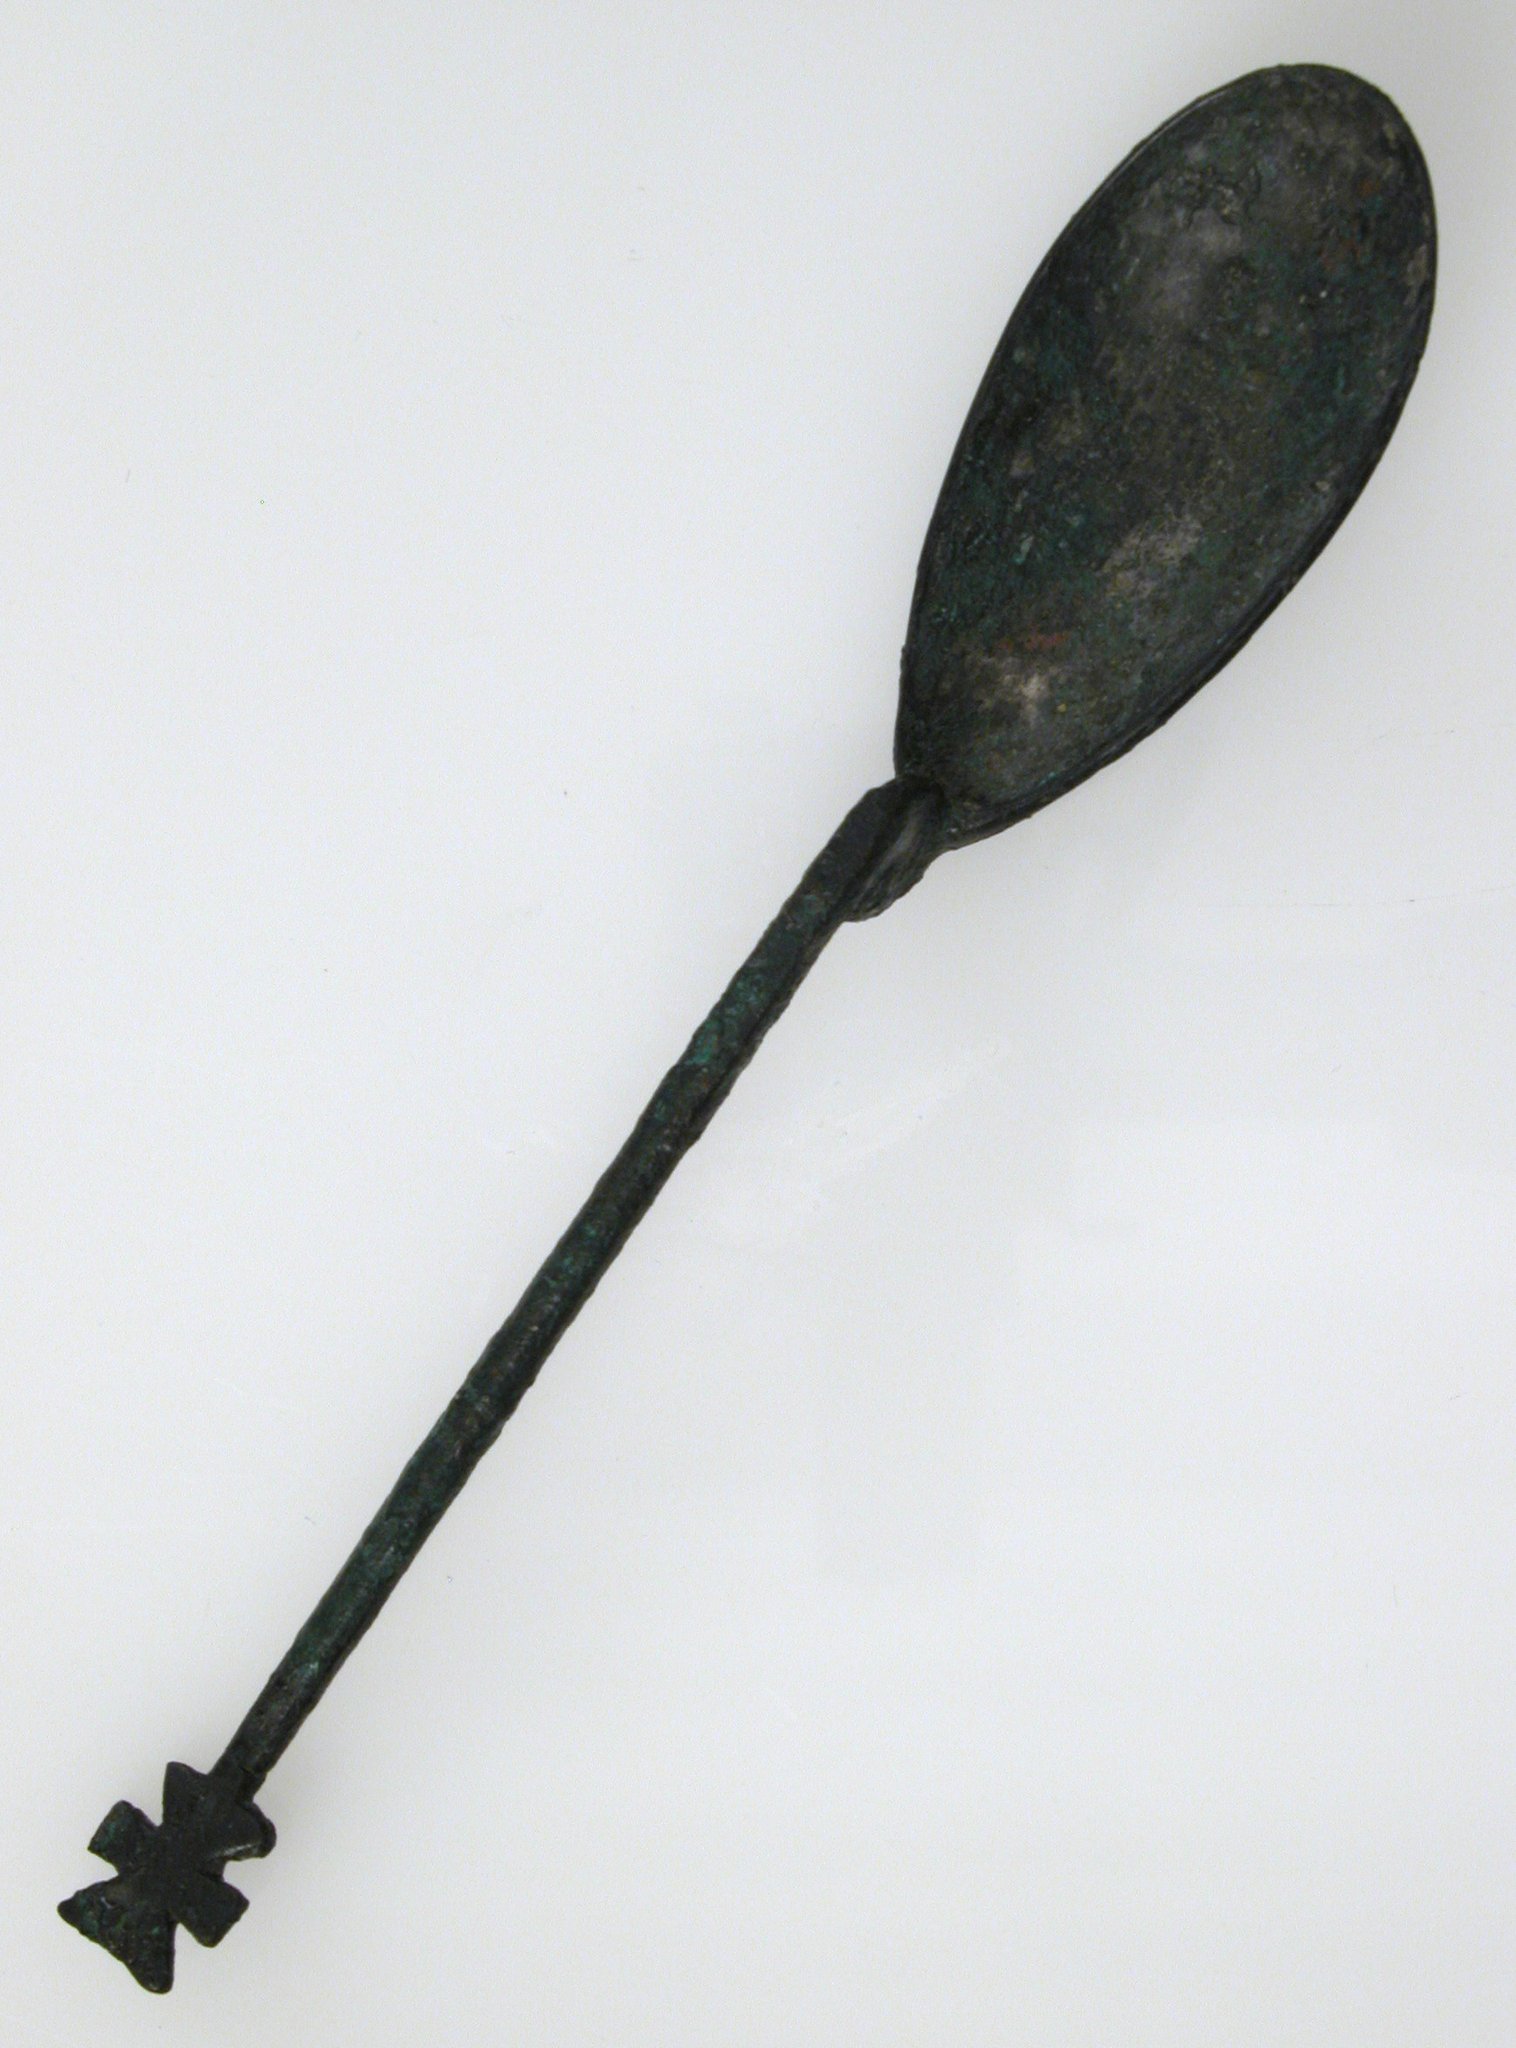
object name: spoon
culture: byzantine or roman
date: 301-500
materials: silver